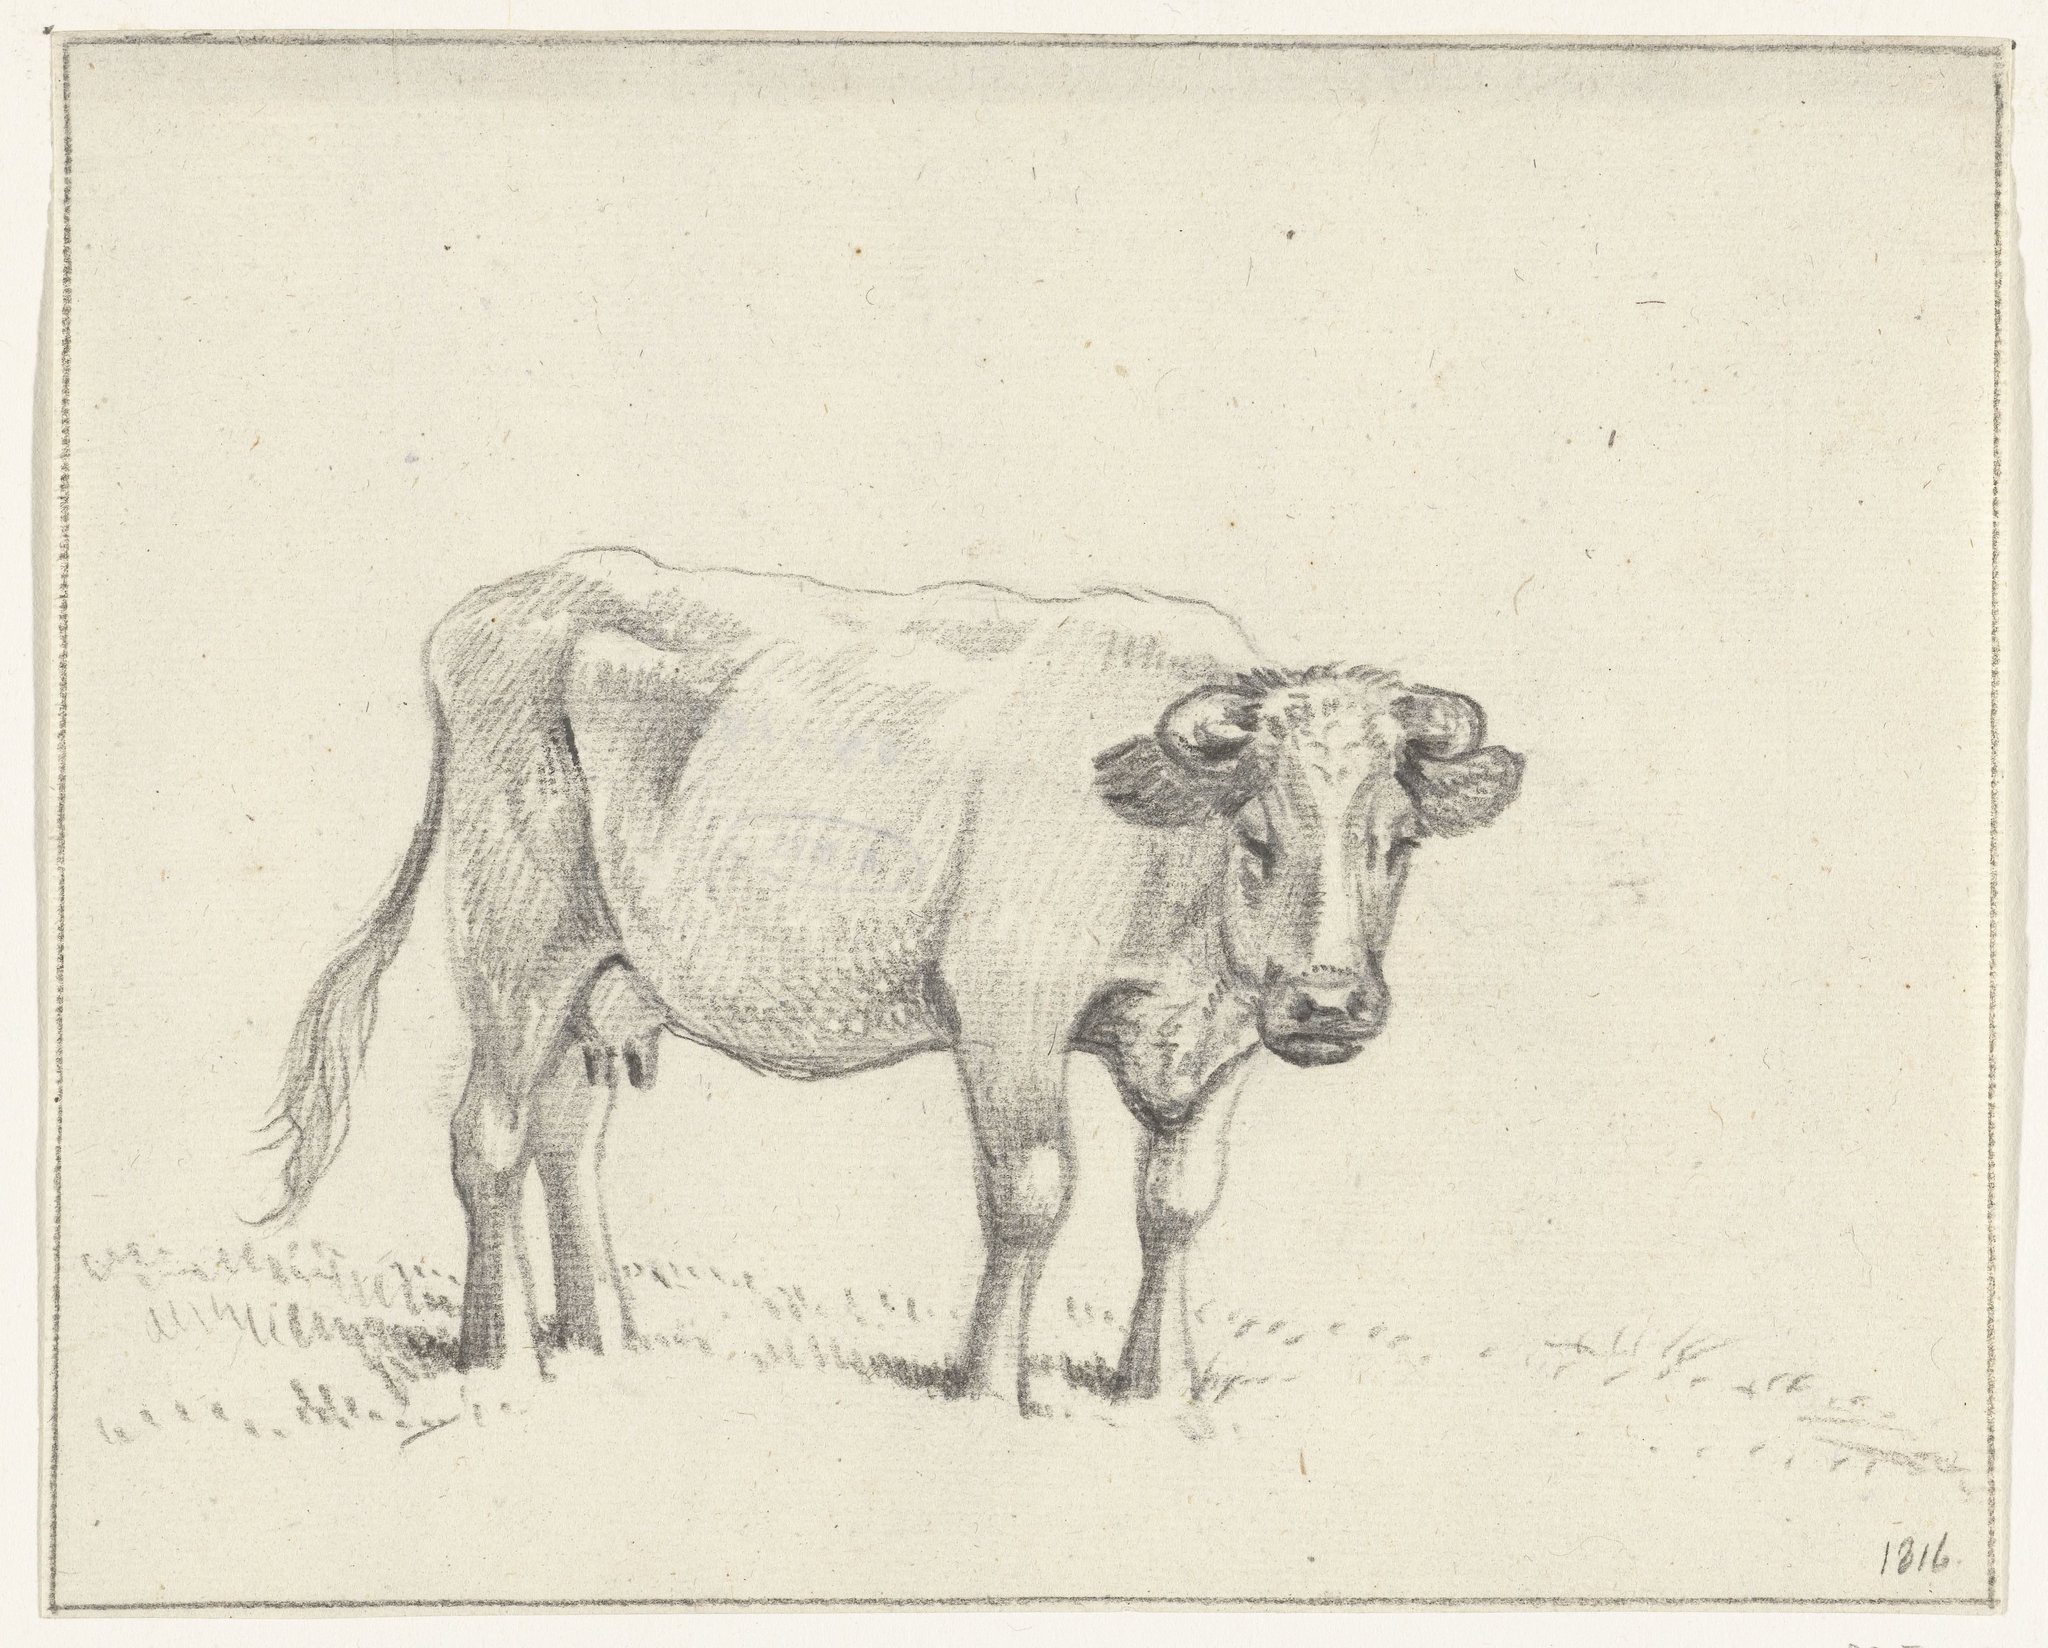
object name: drawing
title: Staande koe, naar rechts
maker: jean bernard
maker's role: draughtsman, print maker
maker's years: 1765-1833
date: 1816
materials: chalk, paper, pencil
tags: cow